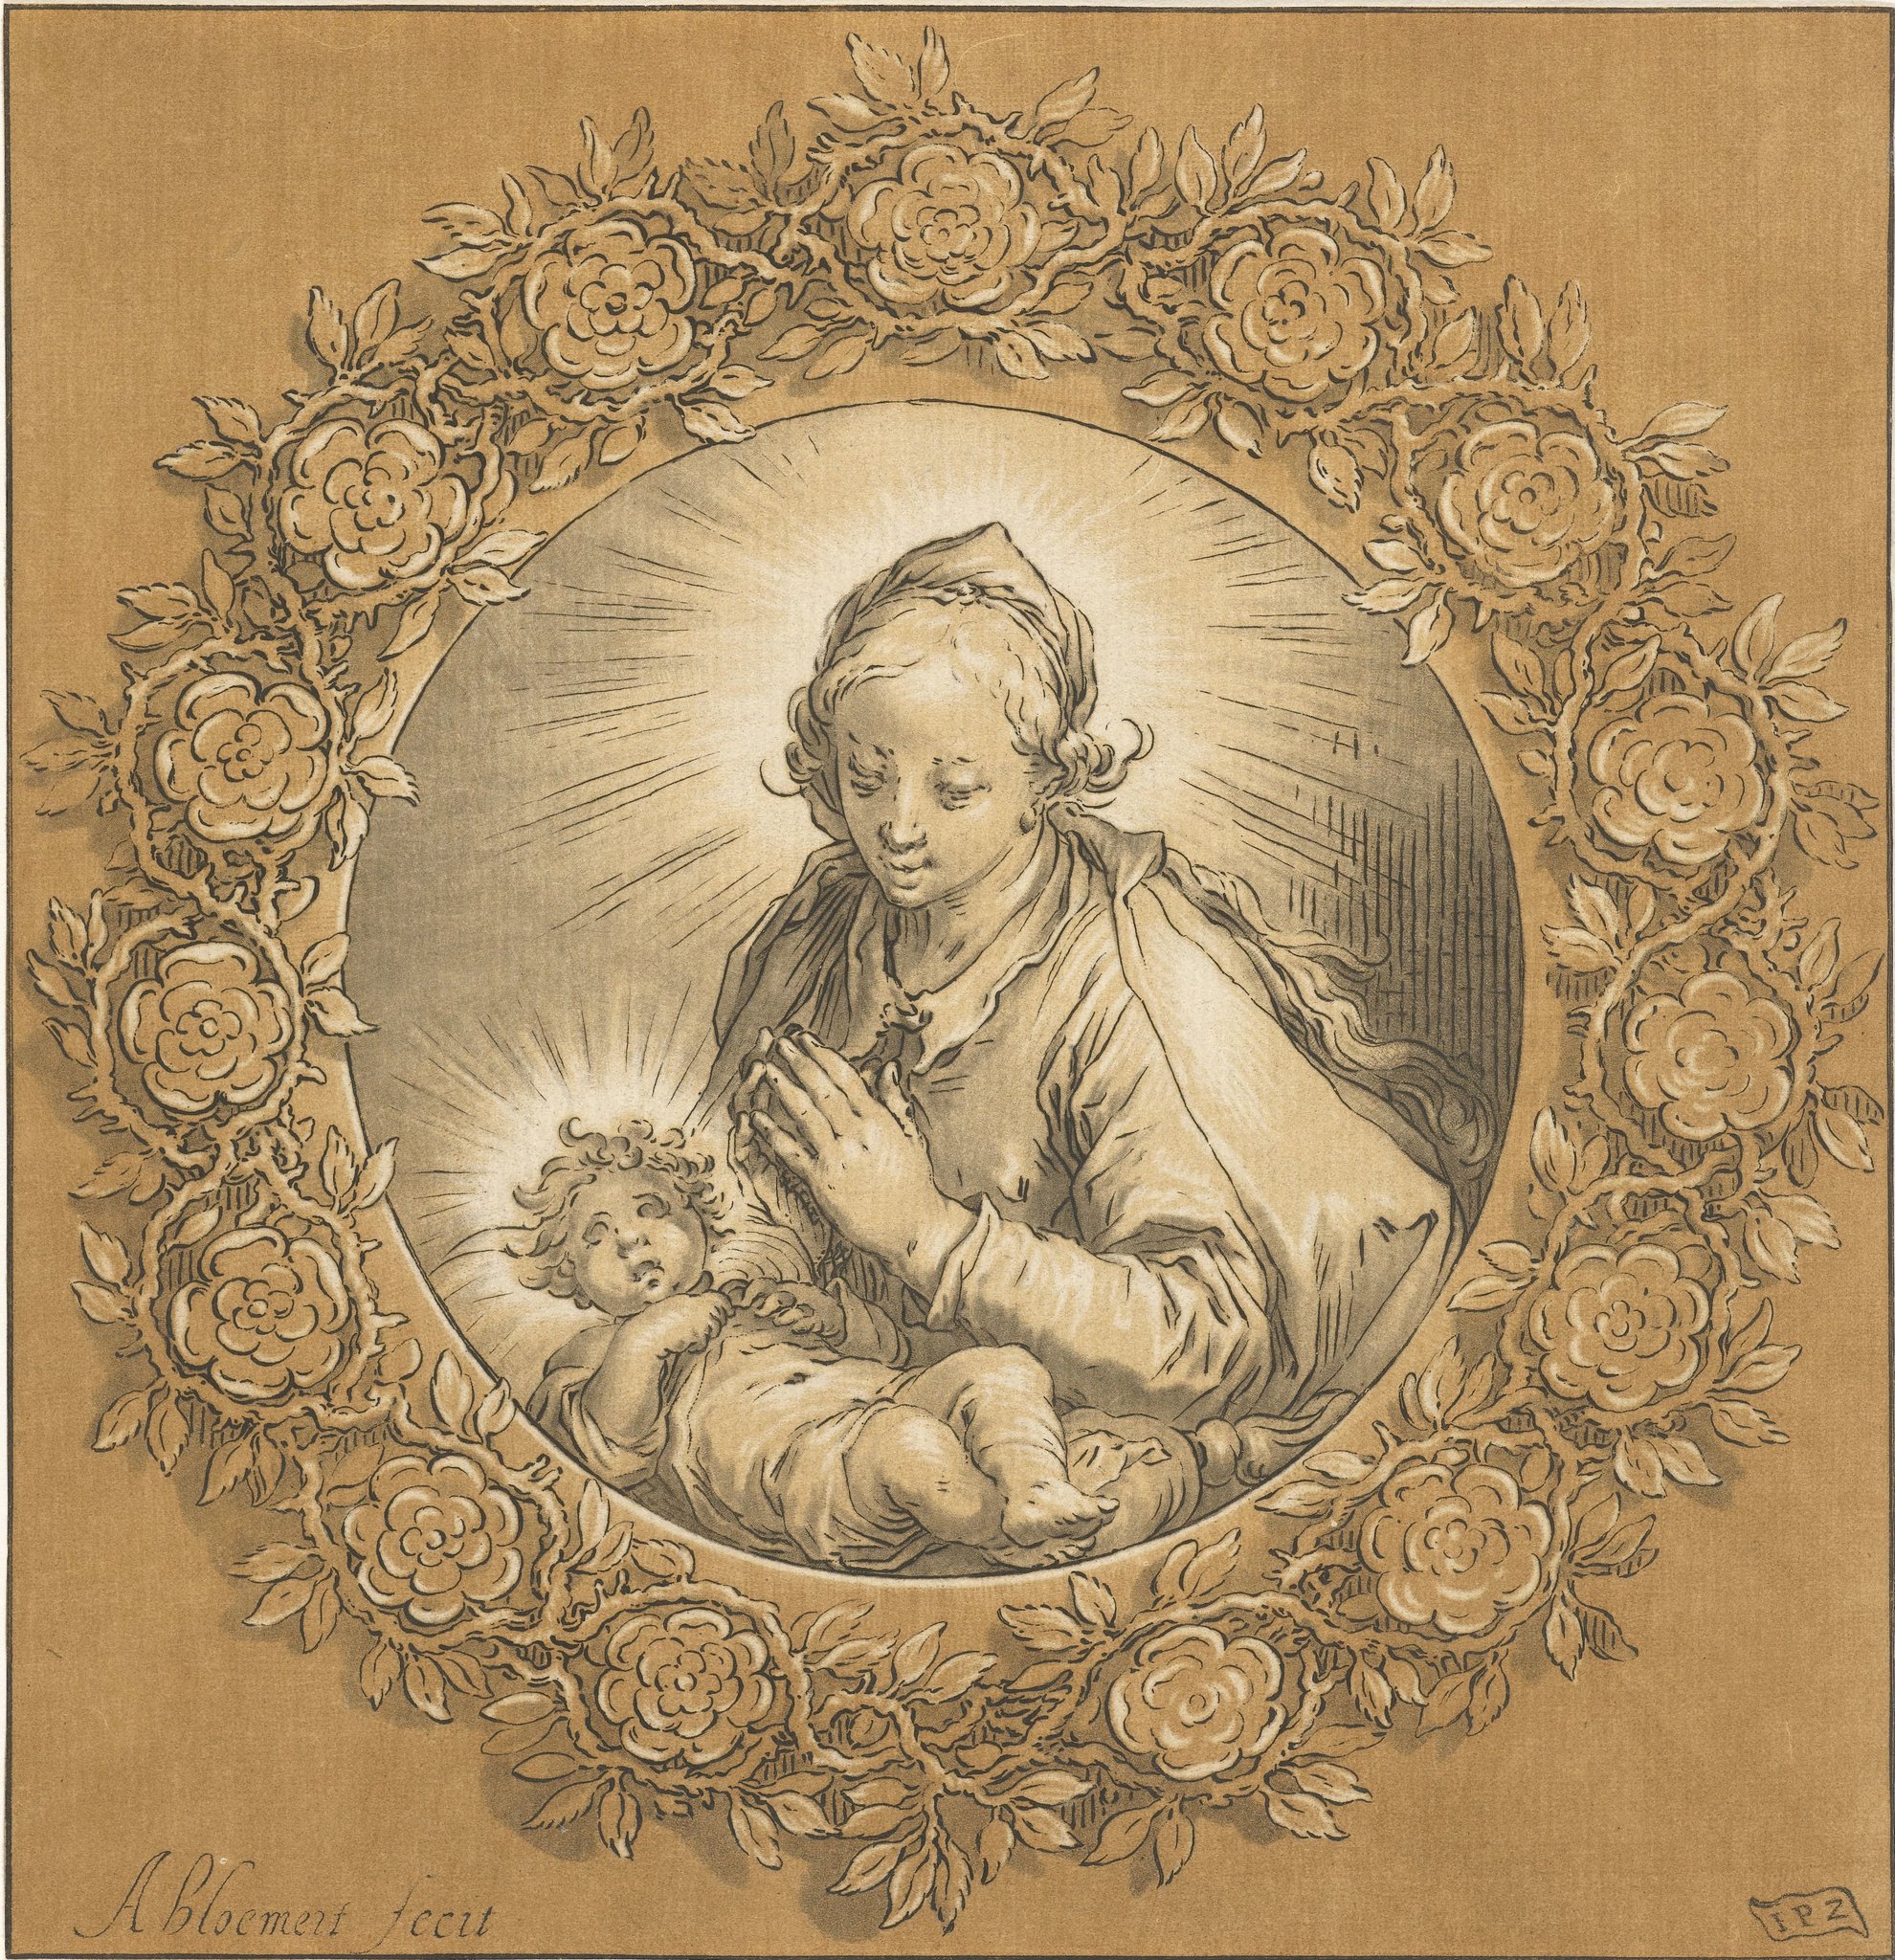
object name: print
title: De Maagd Maria het het Kind Jezus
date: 1769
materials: paper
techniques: etching, roulette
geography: amsterdam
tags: madonna: i.e. mary with the christ-child, flowers: rose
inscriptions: collector's mark: Lugt 2725, collector's mark: Lugt 1511, collector's mark: Lugt 240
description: Maria met gevouwen handen bij het Christuskind in een ronde, met rozen versierde, omlijsting.